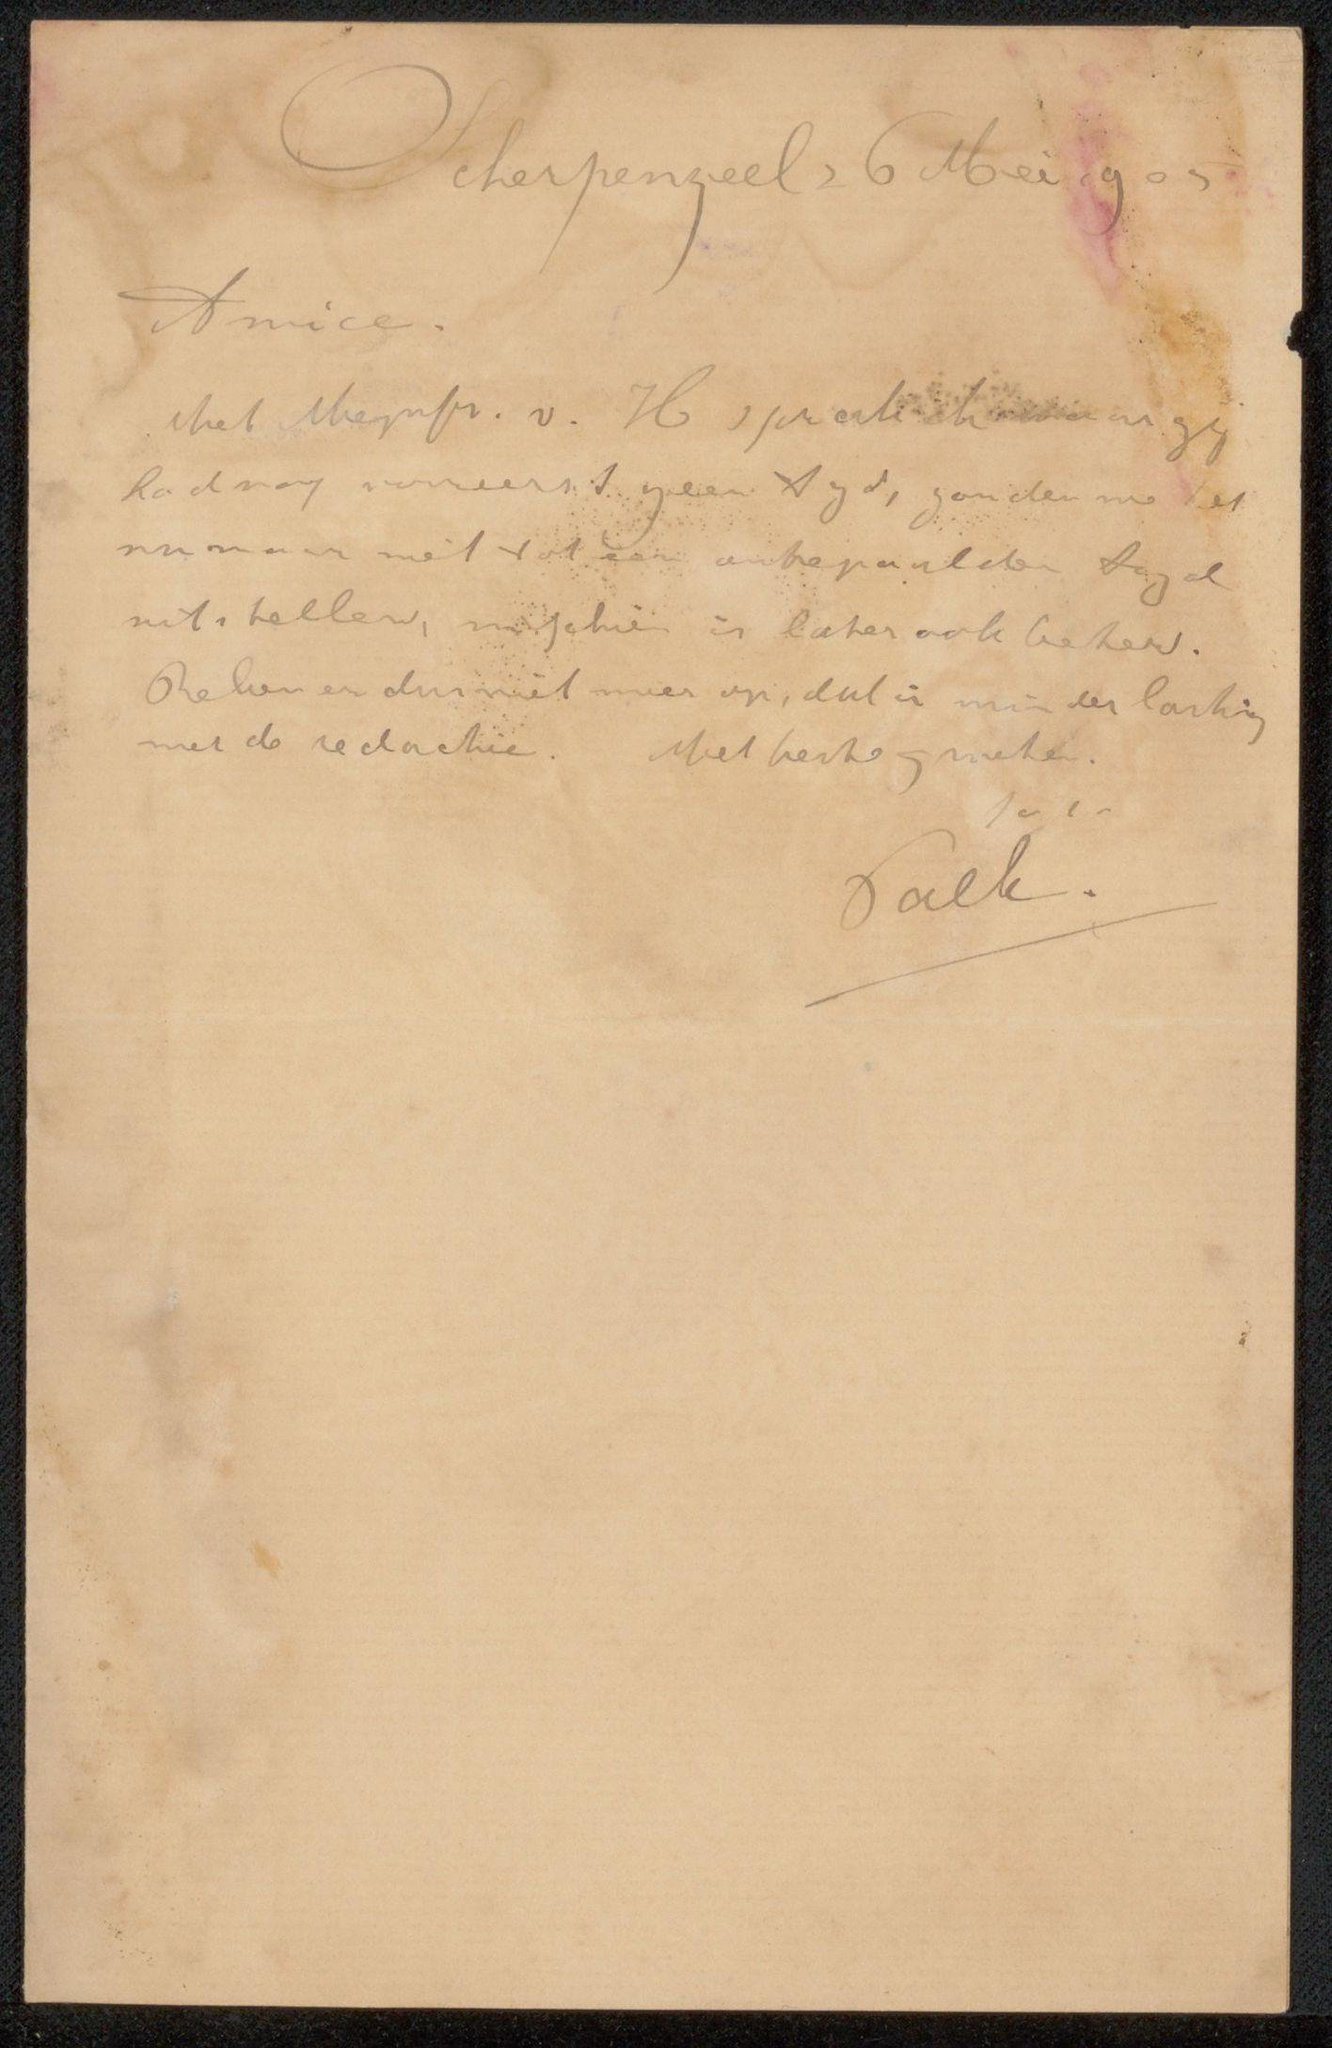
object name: letter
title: Brief aan Philip Zilcken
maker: maurits van der valk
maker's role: draughtsman, print maker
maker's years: 1857-1935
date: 1905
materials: ink, paper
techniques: pen, writing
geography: scherpenzeel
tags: utrecht, the hague, painter, draughtsman, philip zilcken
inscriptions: watermark, collector's mark: ‘RPK’